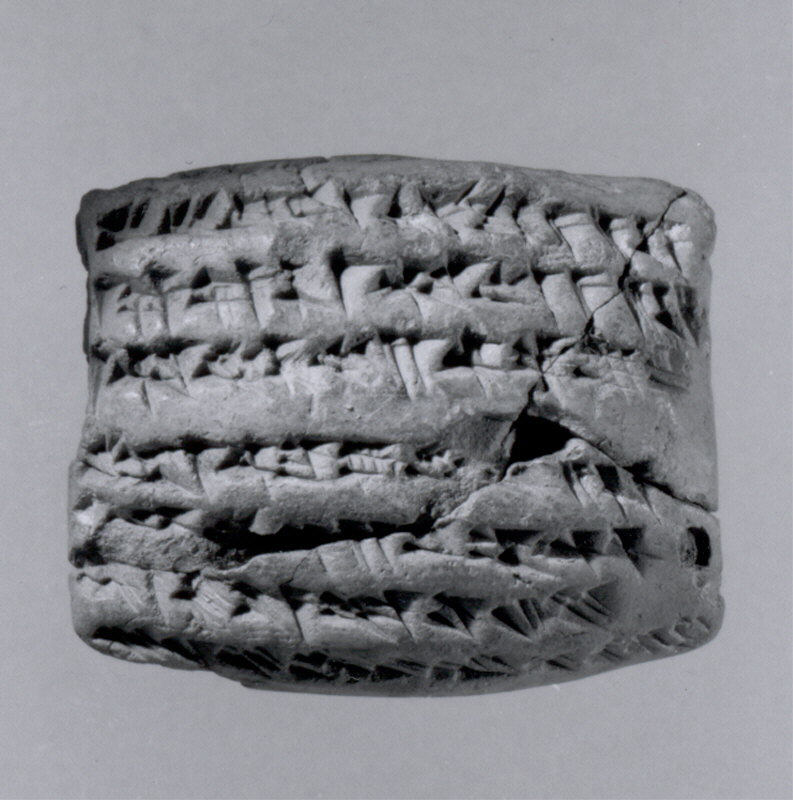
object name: cuneiform tablet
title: Cuneiform tablet: hire contract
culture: babylonian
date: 545 BCE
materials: clay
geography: mesopotamia